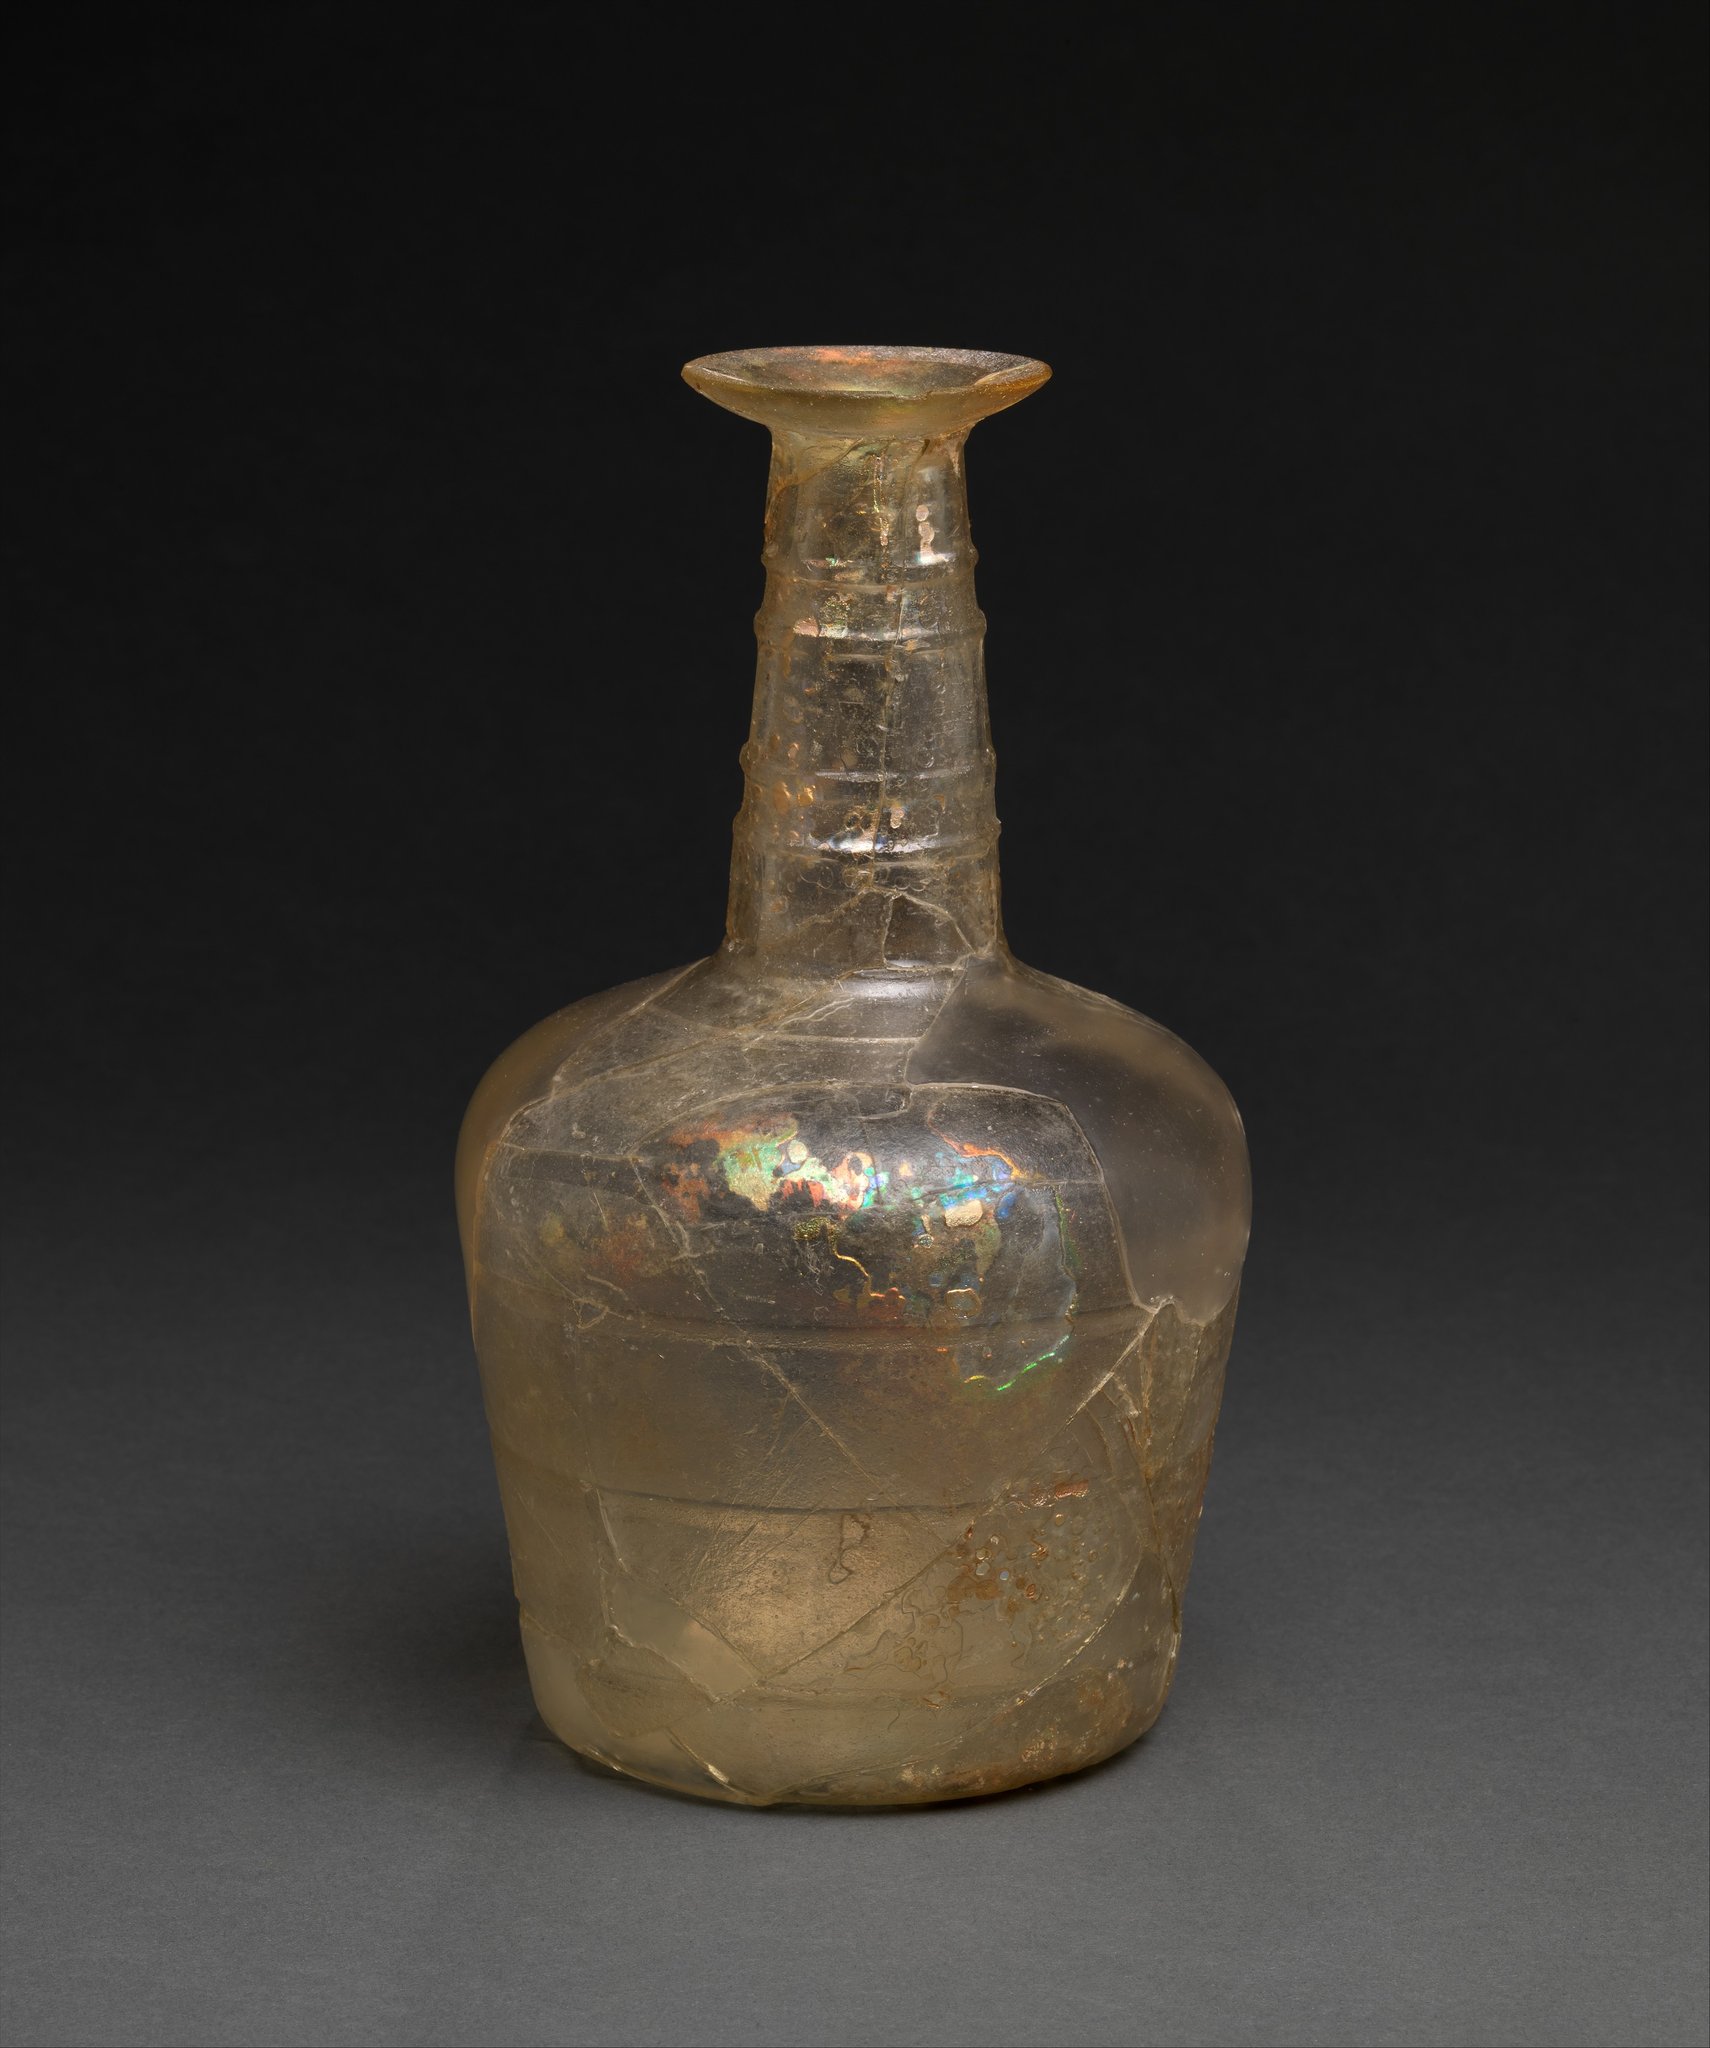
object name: flask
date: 801-900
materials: glass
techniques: cutting, glassblowing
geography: iran